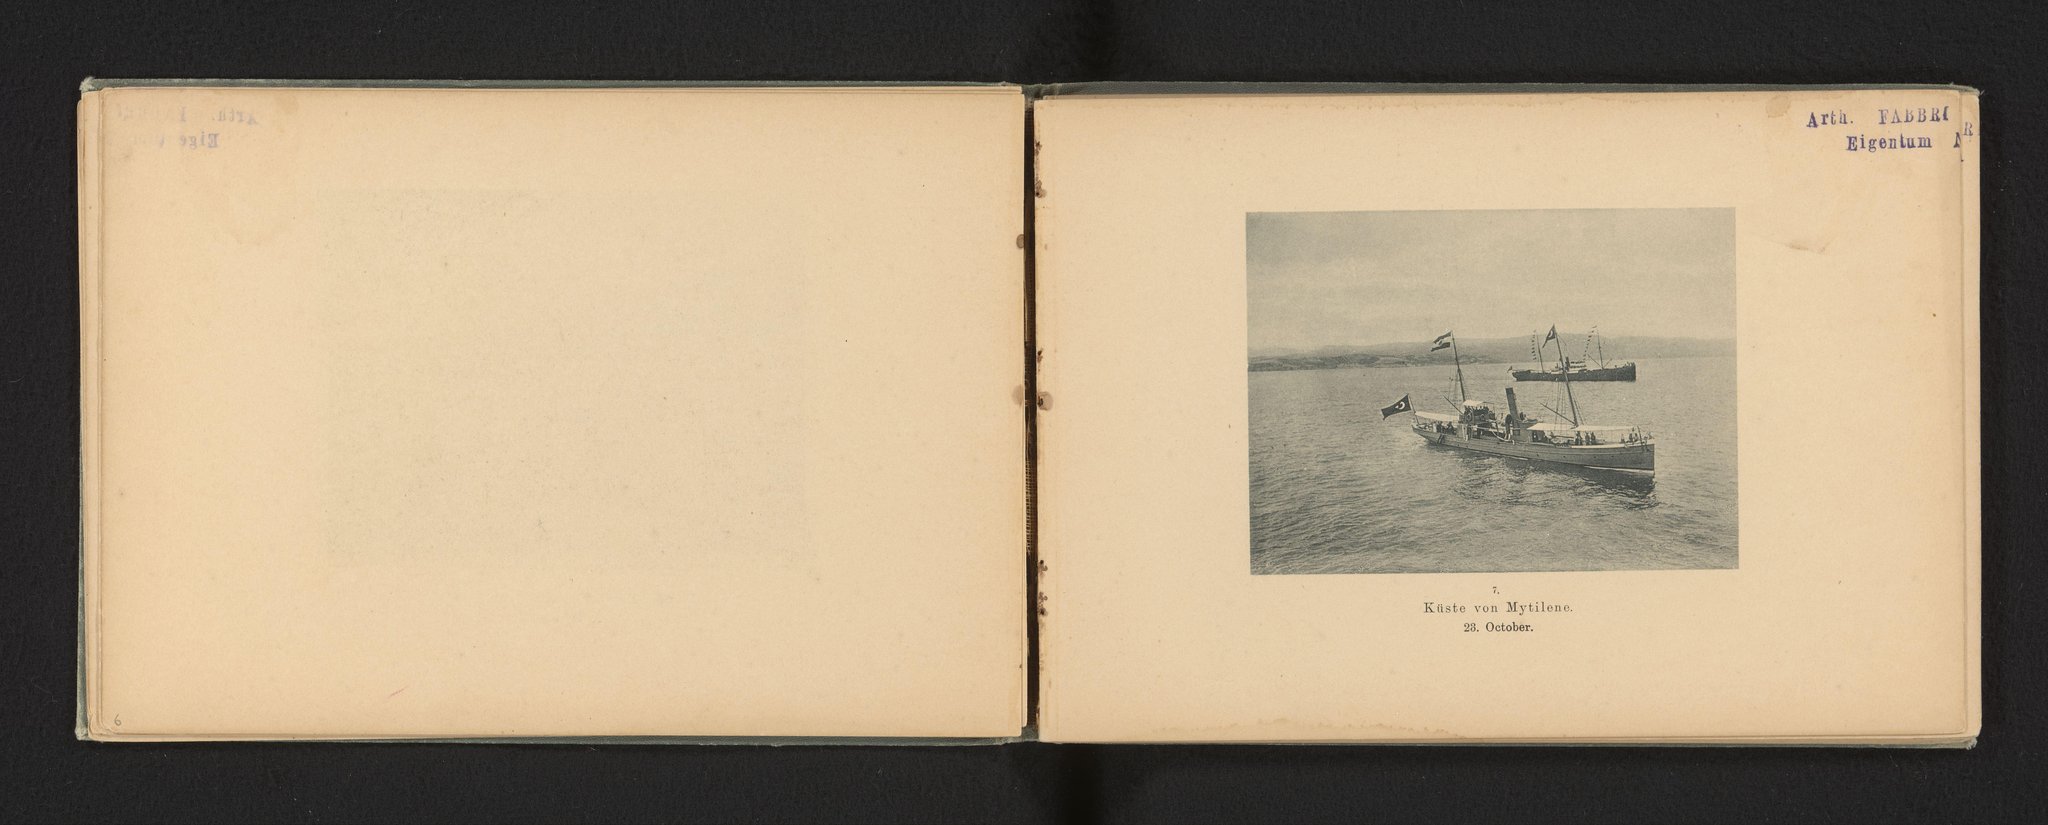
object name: page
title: Gezicht op twee schepen voor de kust van Lesbos, Griekenland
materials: paper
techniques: photograph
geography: lesbos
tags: coast, steamship, motorship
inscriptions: collector's mark: ‘Arth. FABBR[I]/ Eigentum [.]’, number: ‘7.’